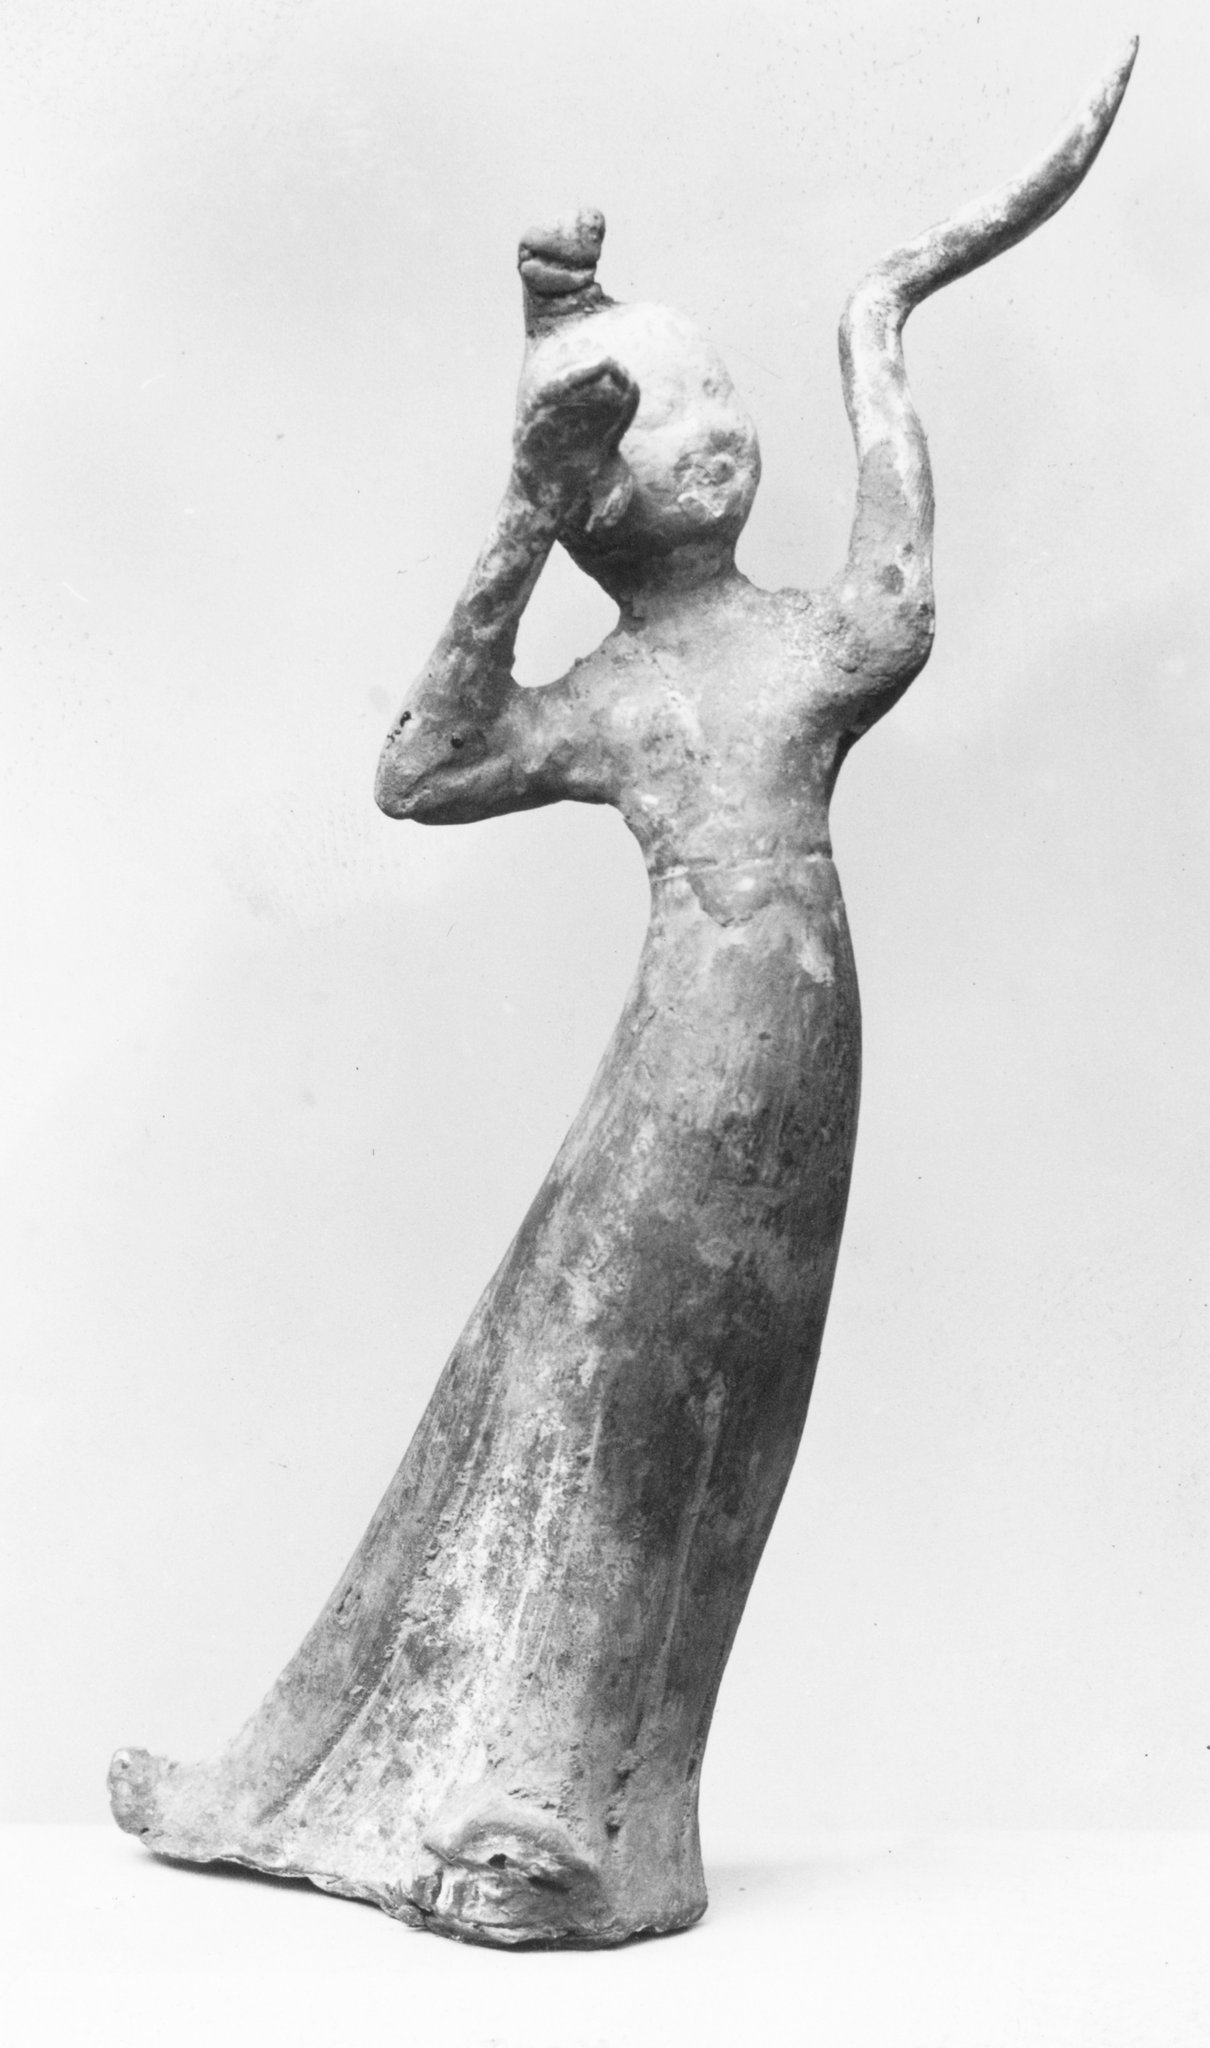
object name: figure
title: Female dancer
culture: chinese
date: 601-800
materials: earthenware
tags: human figures